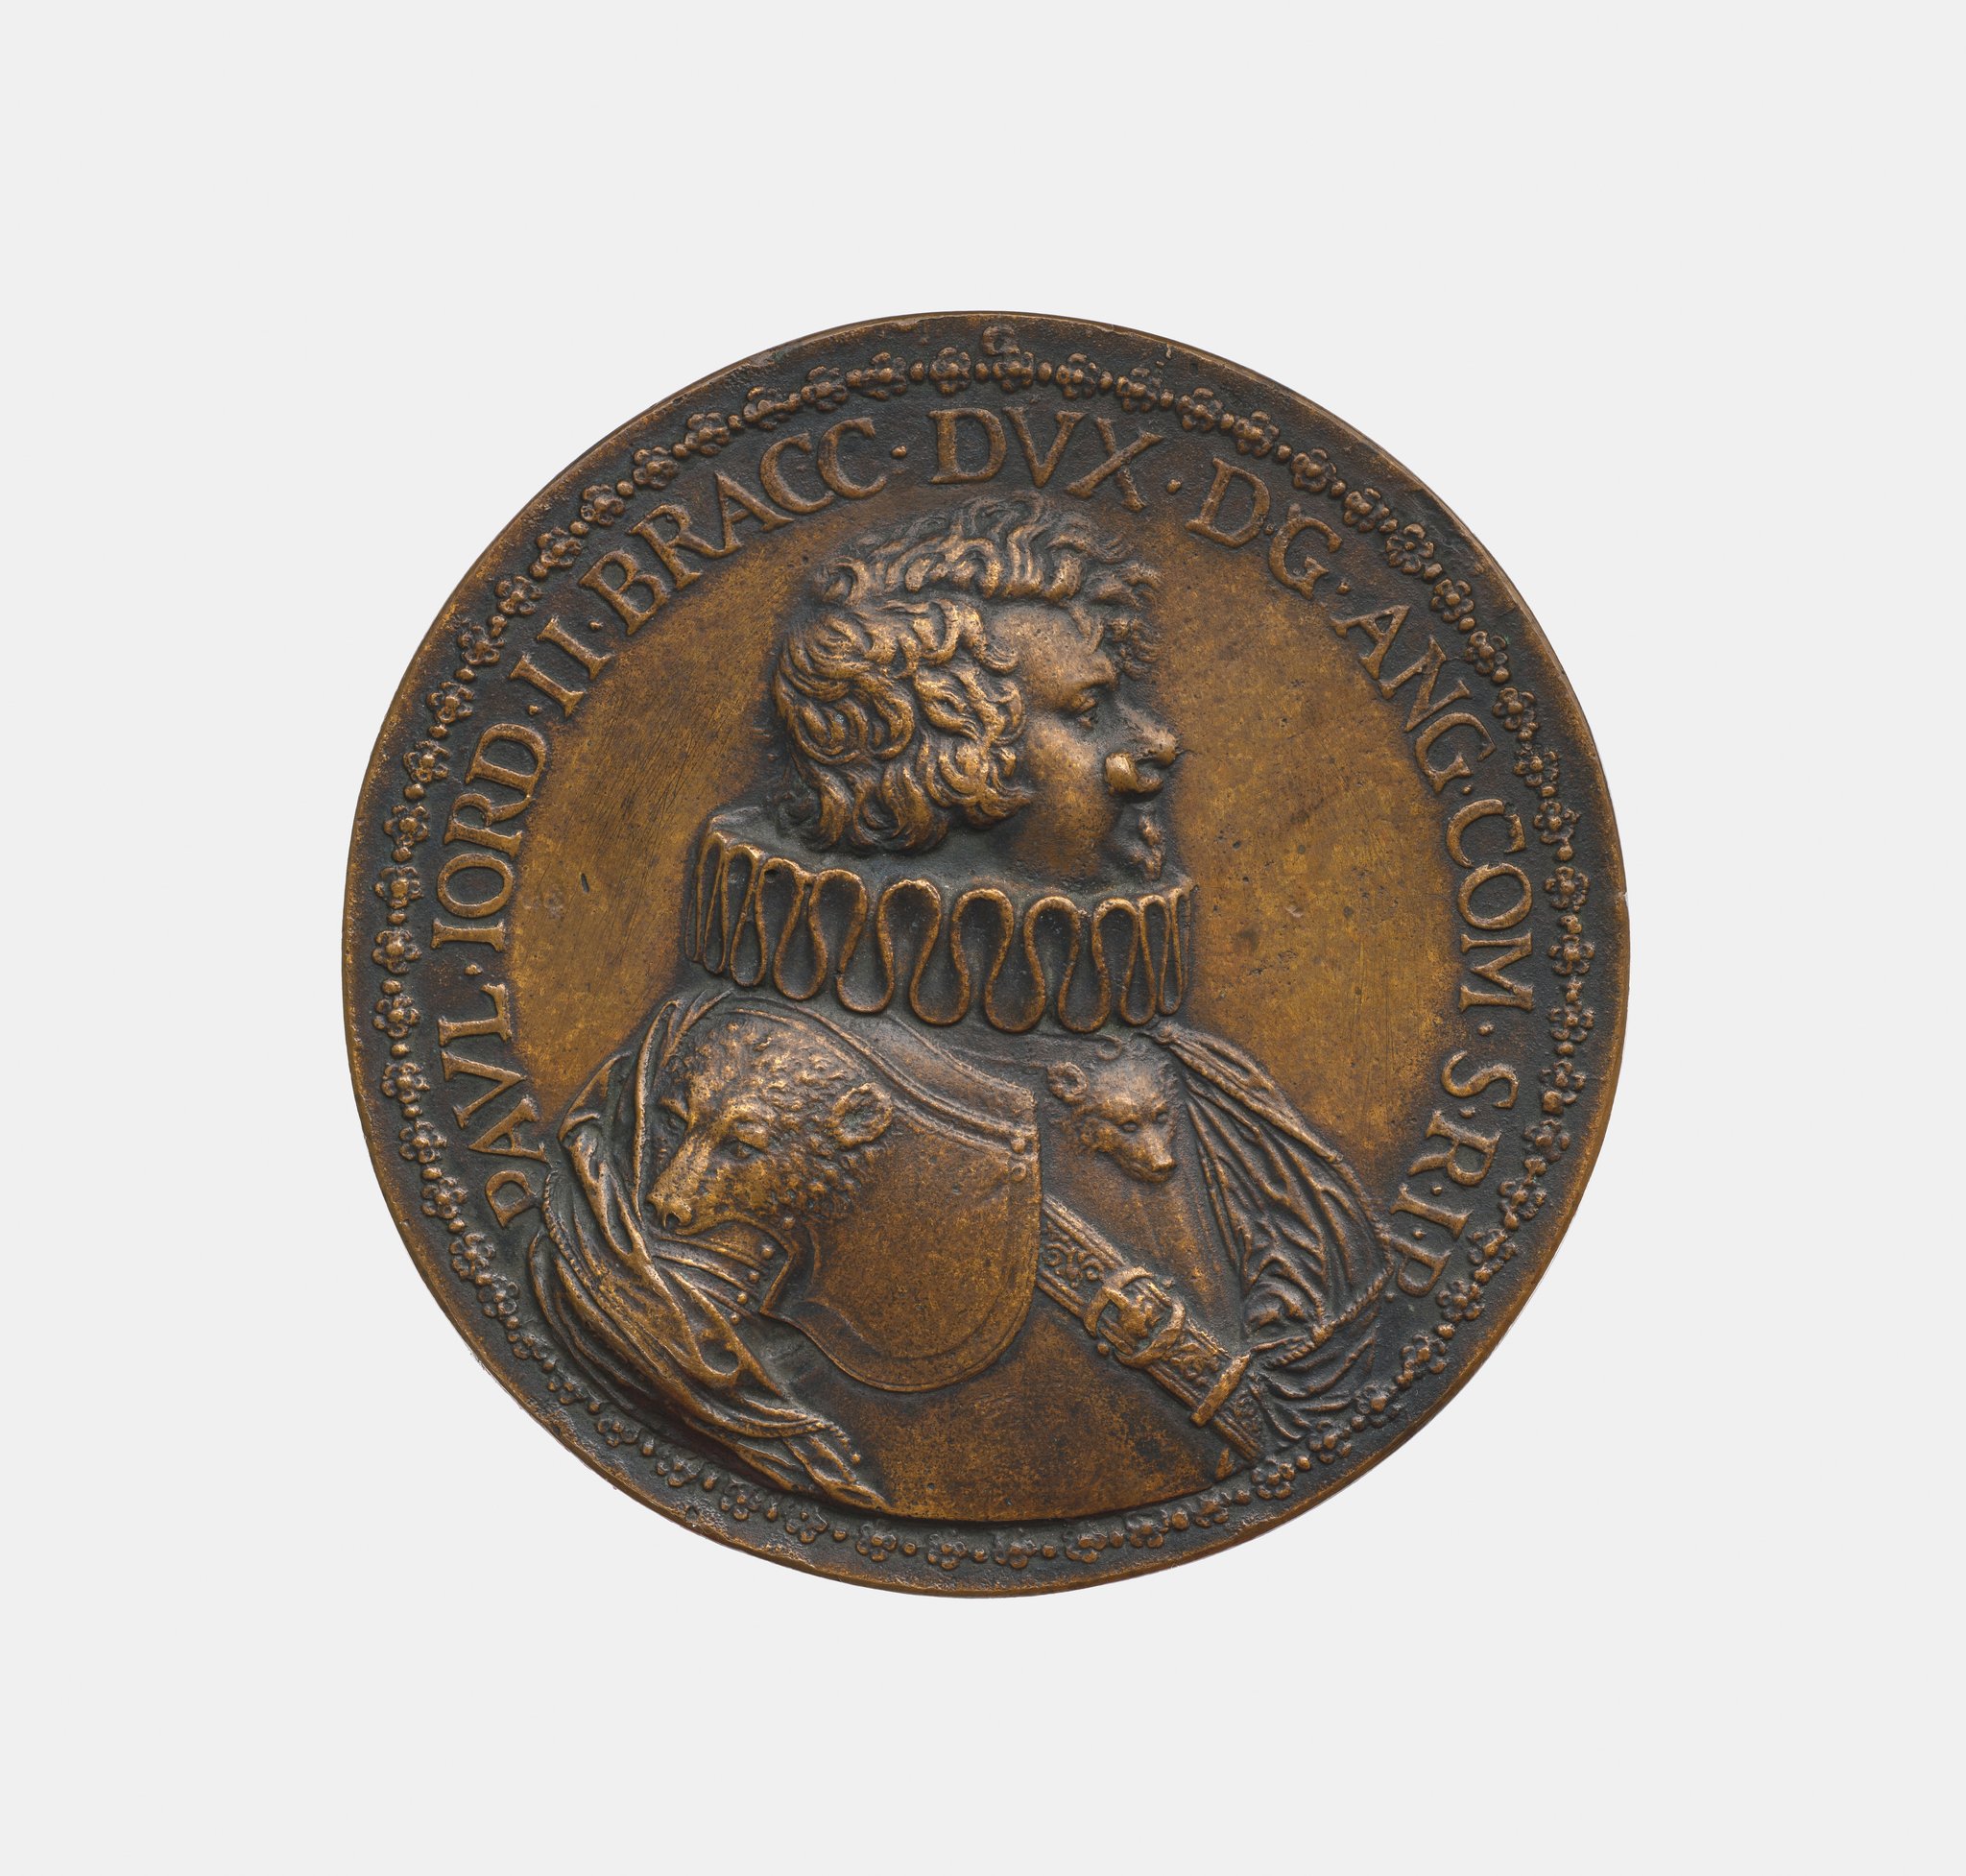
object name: medal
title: Paolo Giordano II Orsini, Duke of Bracciano (1591–1656)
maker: johann jakob kornmann (called cormano)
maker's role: artist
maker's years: 1620-1700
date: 1631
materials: bronze